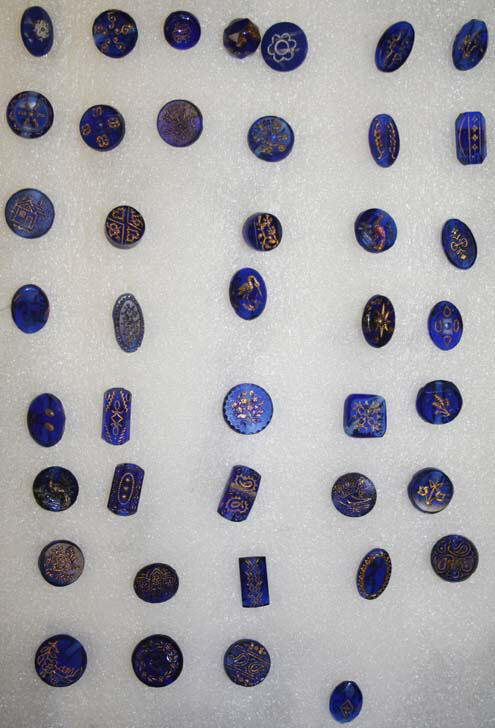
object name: button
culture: american or european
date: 1880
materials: glass